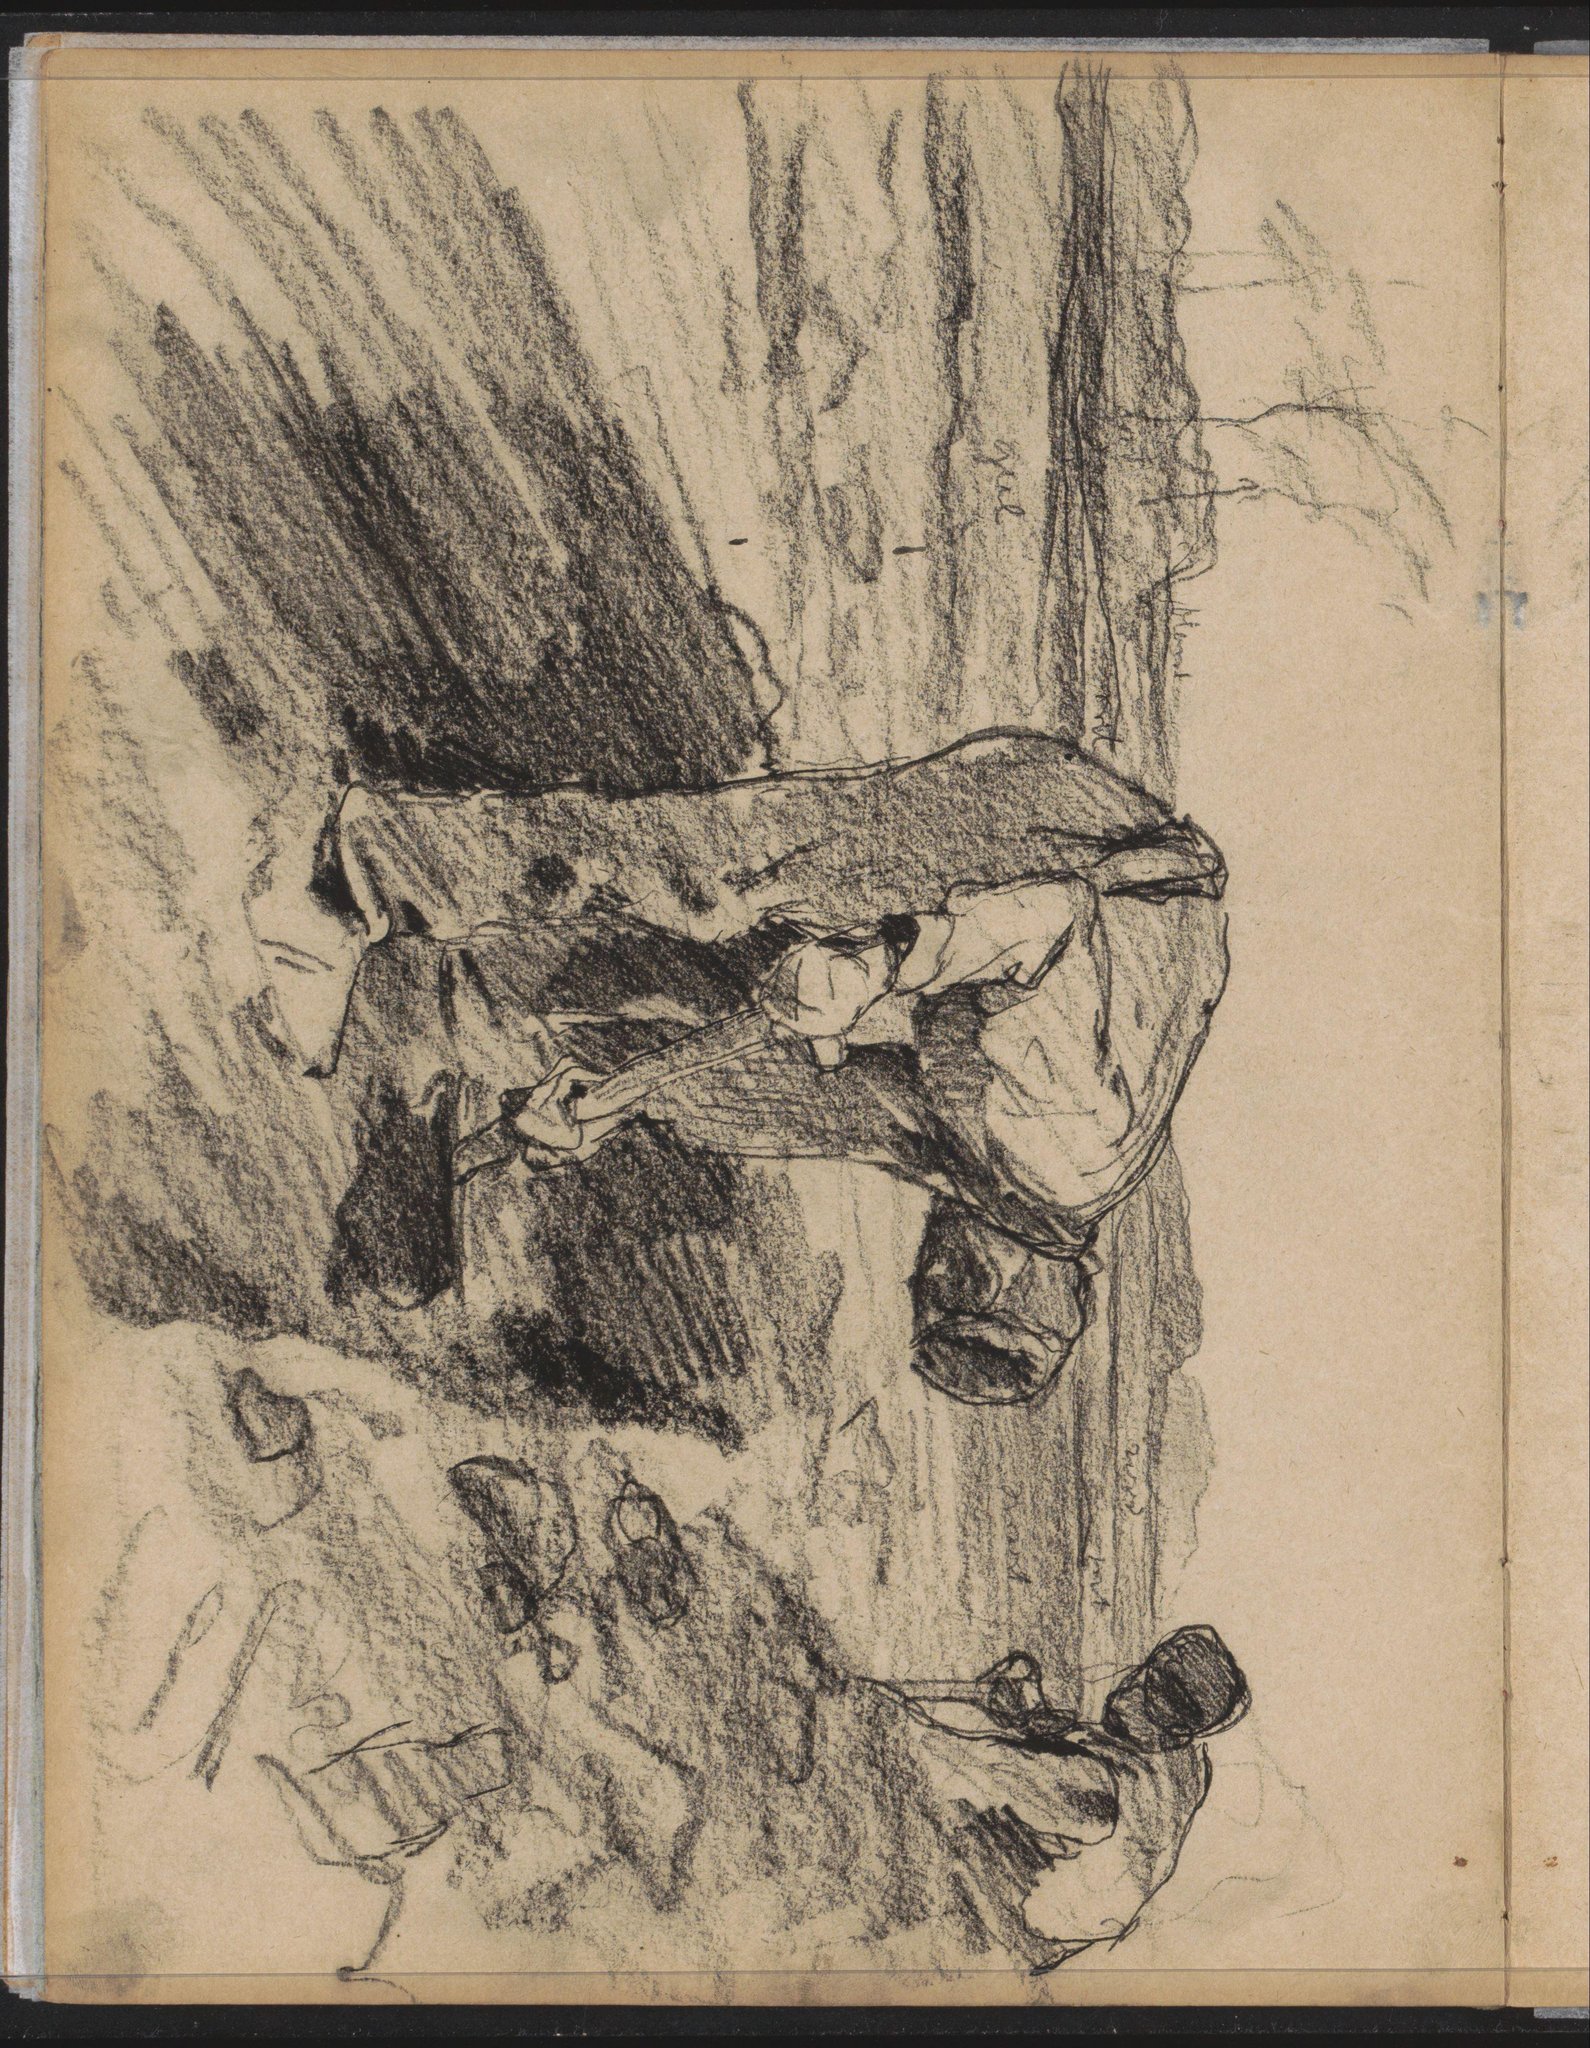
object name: sketchbook leaf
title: Gravende heiwerkers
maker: willem witsen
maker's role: draughtsman, painter, print maker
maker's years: 1860-1923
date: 1884-1887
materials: chalk, paper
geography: ewijkshoeve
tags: building-site (+ men (labourers))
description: Pagina 40 uit een schetsboek met 49 bladen.